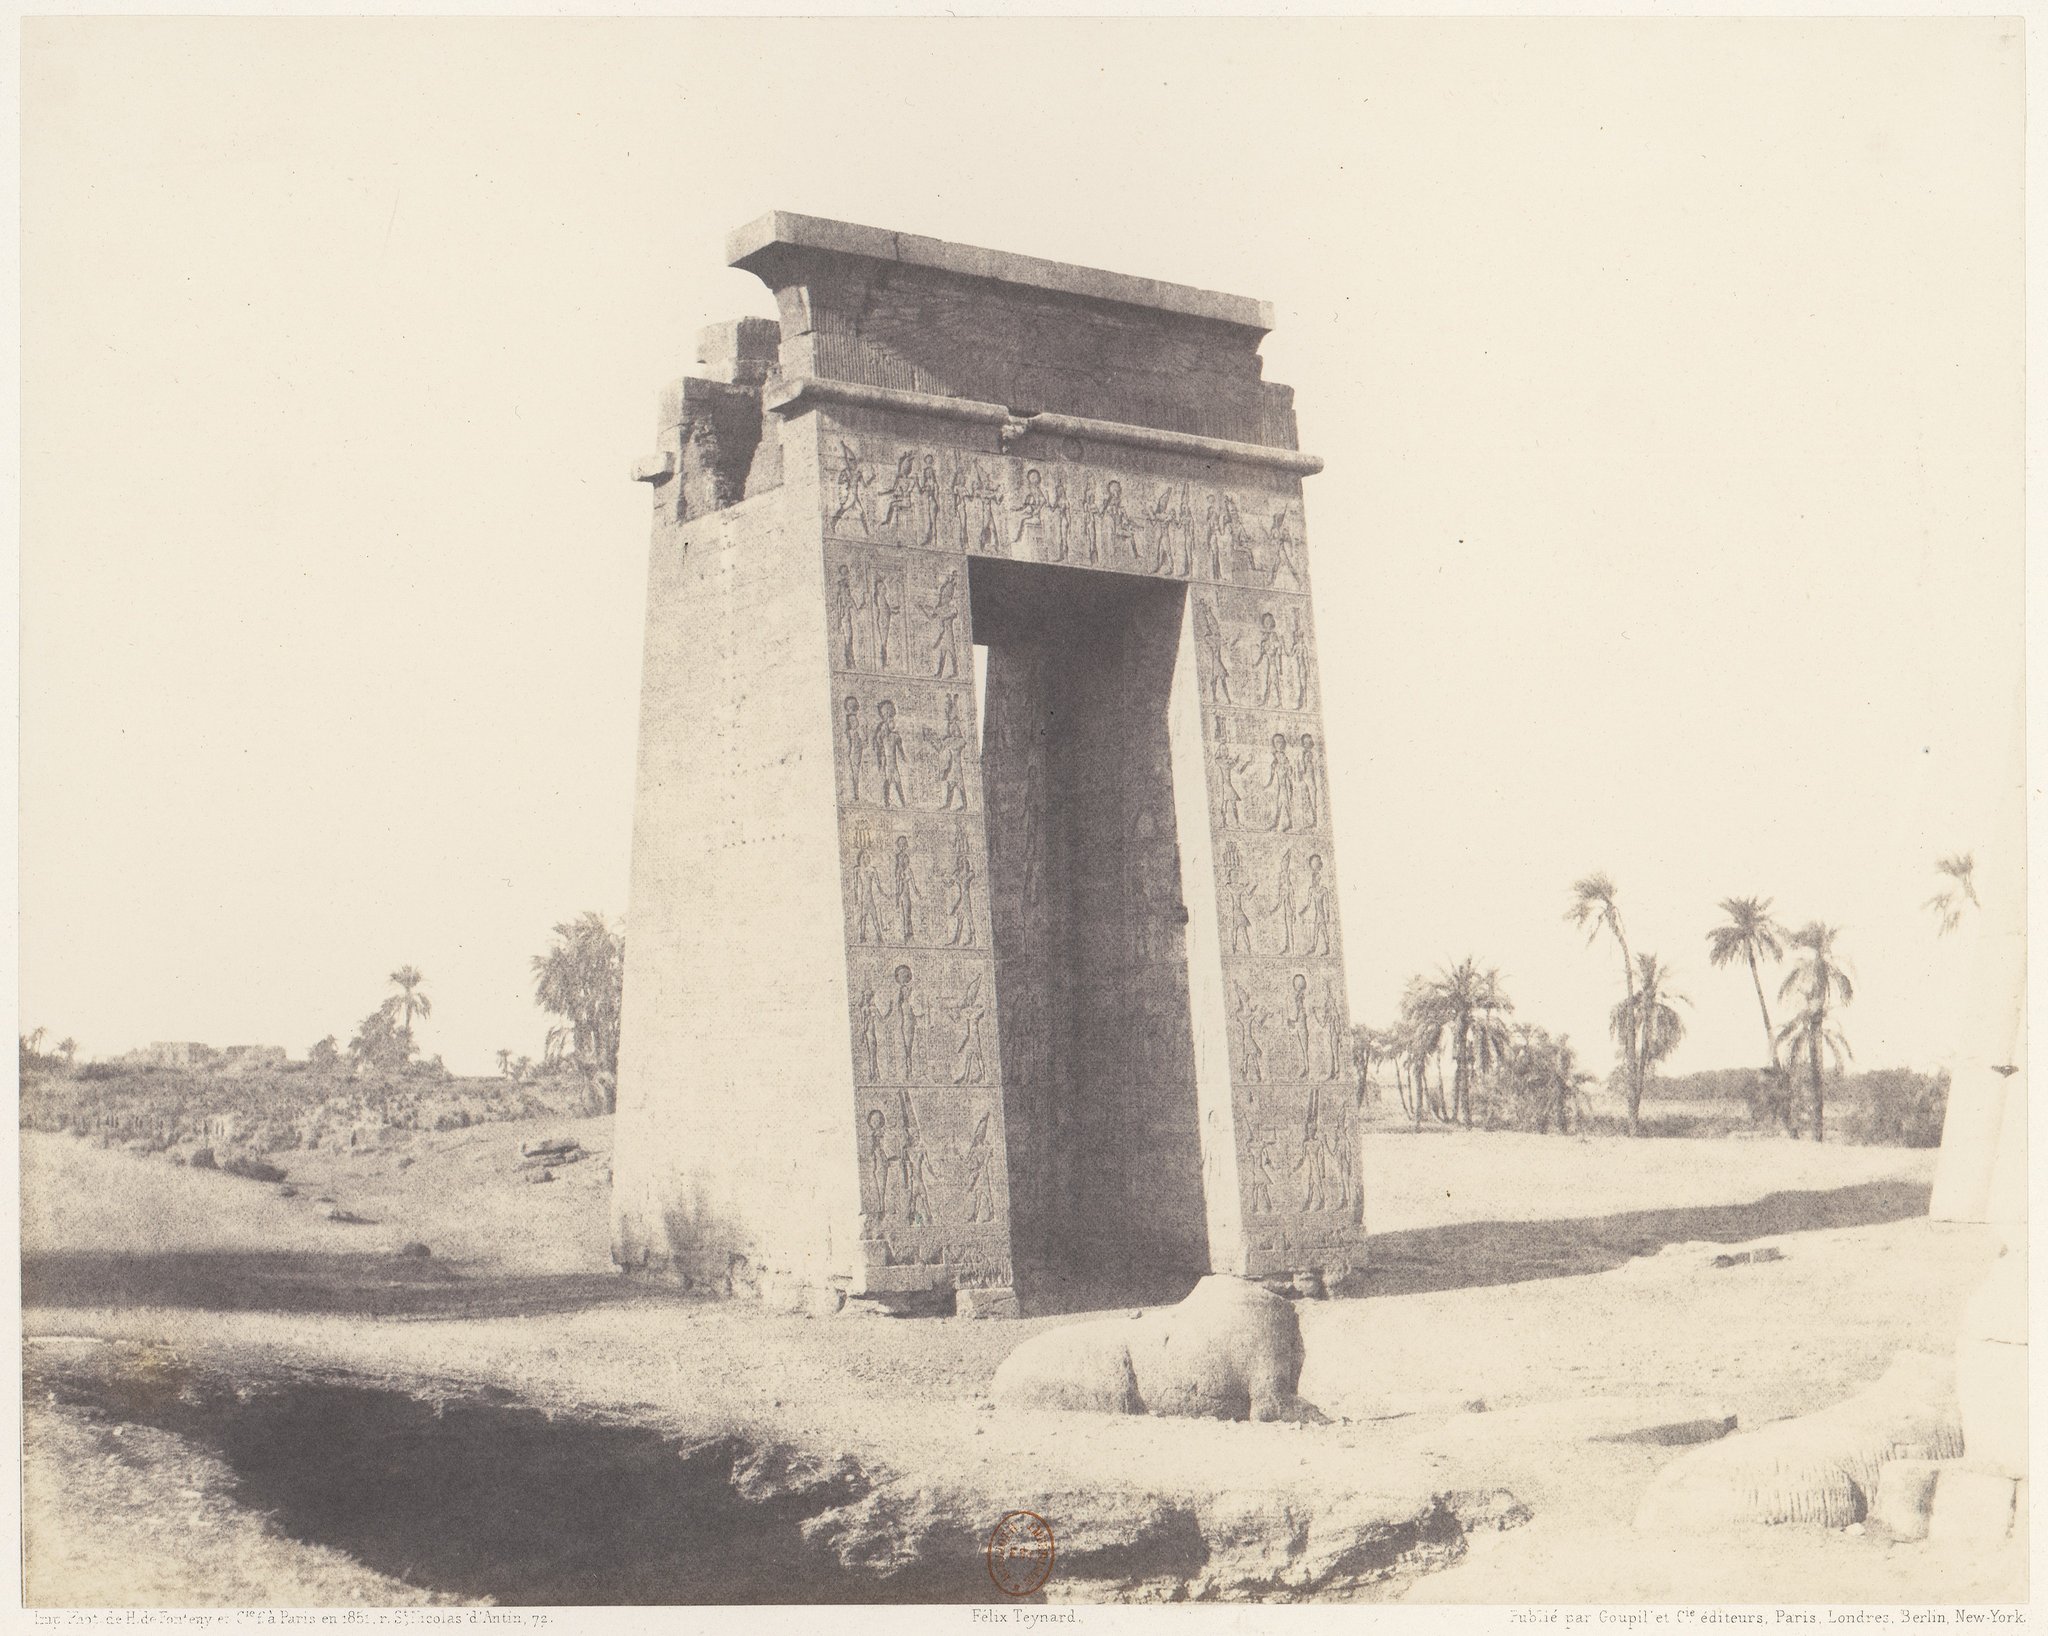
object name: photograph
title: Karnak (Thèbes), Grande Porte du Sud Vue du Point C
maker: félix teynard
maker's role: artist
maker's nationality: french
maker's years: 1817-1892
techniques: paper negative, salted paper print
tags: architecture,gates,ruins,hieroglyphs